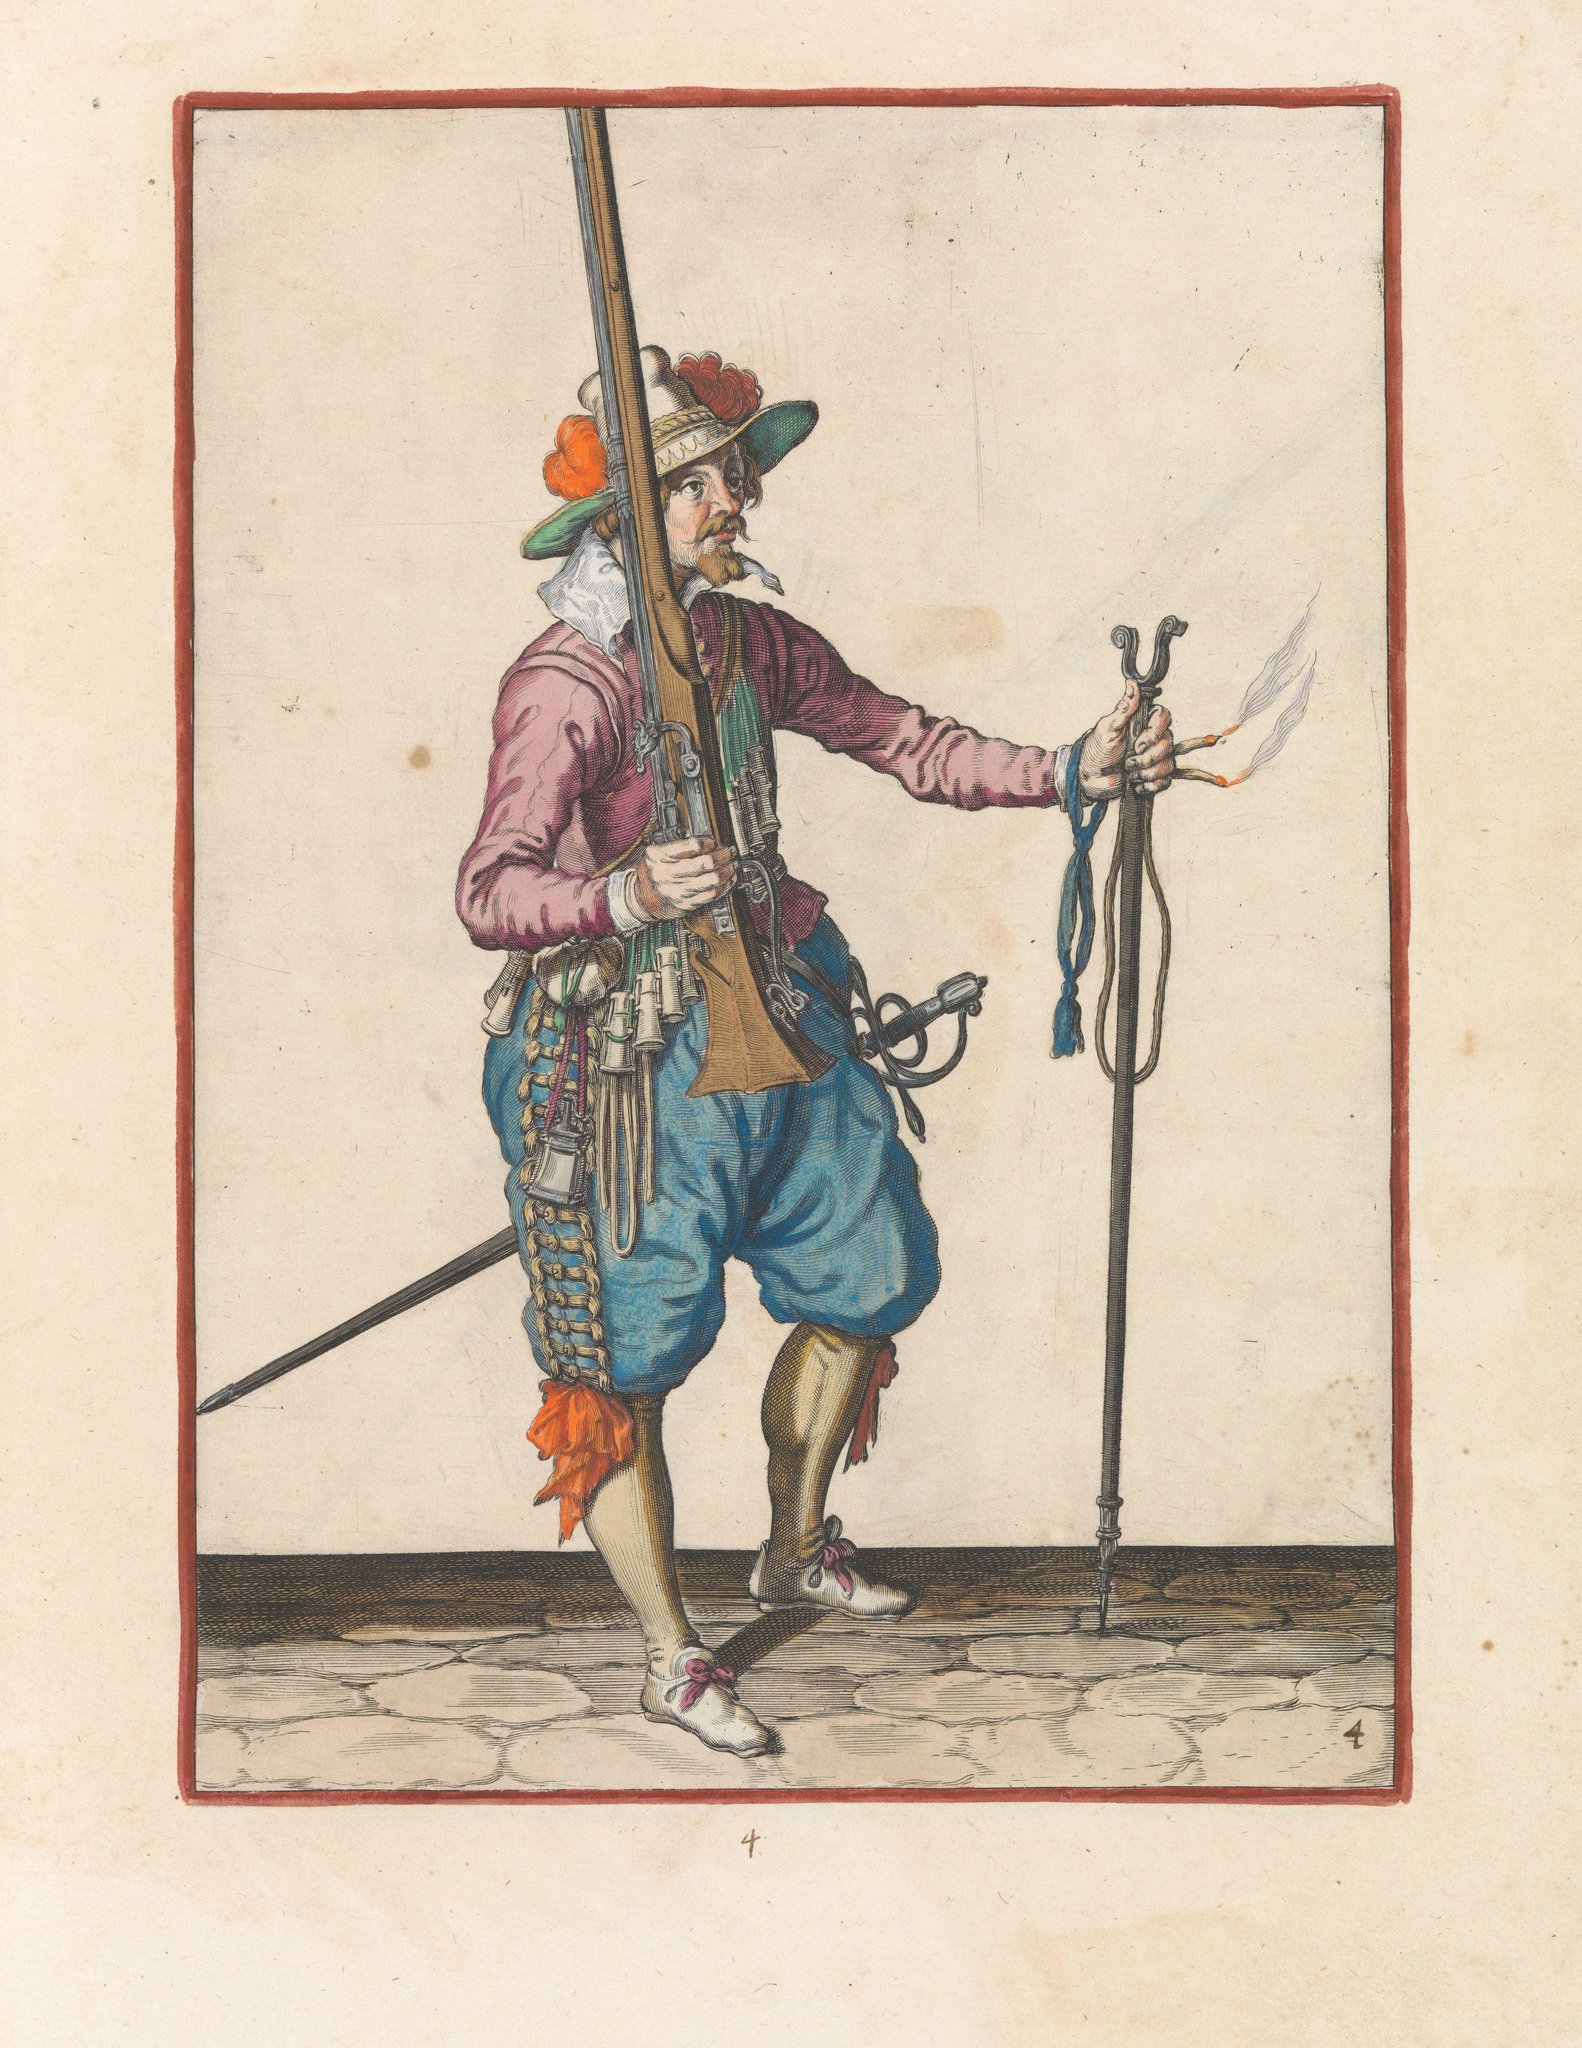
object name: print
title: Soldaat die zijn musket met zijn rechterhand rechtop vasthoudt, in zijn linkerhand het furket om zijn wapen op te plaatsen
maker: jacques de gheyn (ii)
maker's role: painter, print maker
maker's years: 1565-1629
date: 1597-1607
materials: paper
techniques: engraving, hand coloring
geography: the hague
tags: handling of weapons ~ military training, firearms: rifle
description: Een soldaat, ten voeten uit, naar rechts, die een musket (een bepaald type vuurwapen) met zijn rechterhand vasthoudt, de loop omhoog wijzend. In zijn uitgestoken linkerhand een brandende lont en een furket (musketvork), waarop hij zijn wapen kan plaatsen. Deze prent is onderdeel van de reeks van 43 met de hand genummerde prenten van musketiers in de Wapenhandelinghe.